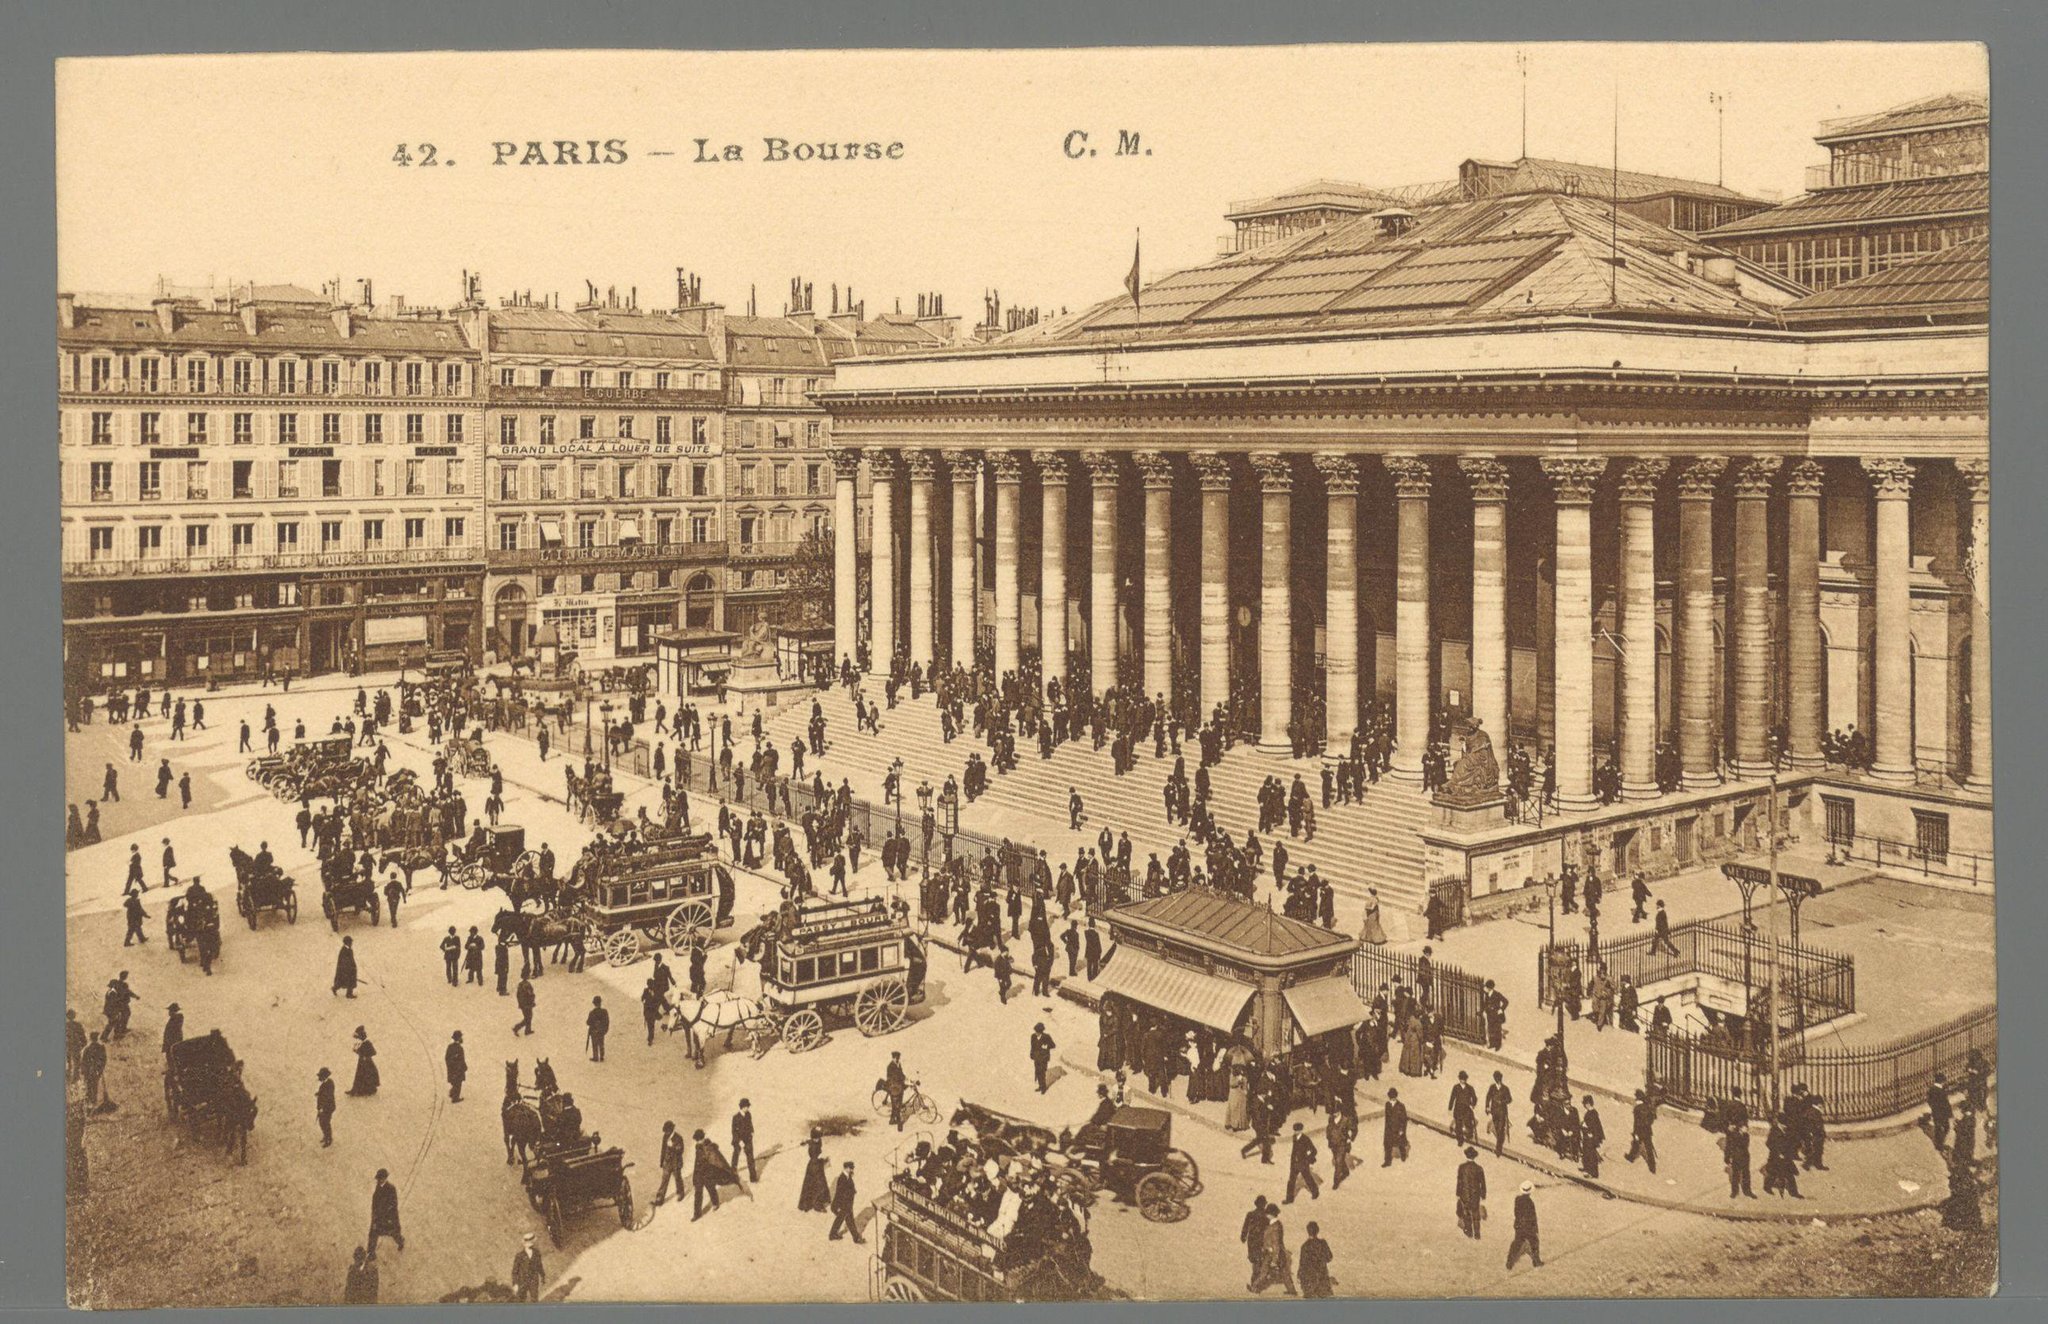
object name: photomechanical print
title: Paris. La Bourse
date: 1903-1920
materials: cardboard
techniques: photograph, writing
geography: paris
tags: exchange, bourse, square, place, circus, etc. (+ city(-scape) with figures, staffage)